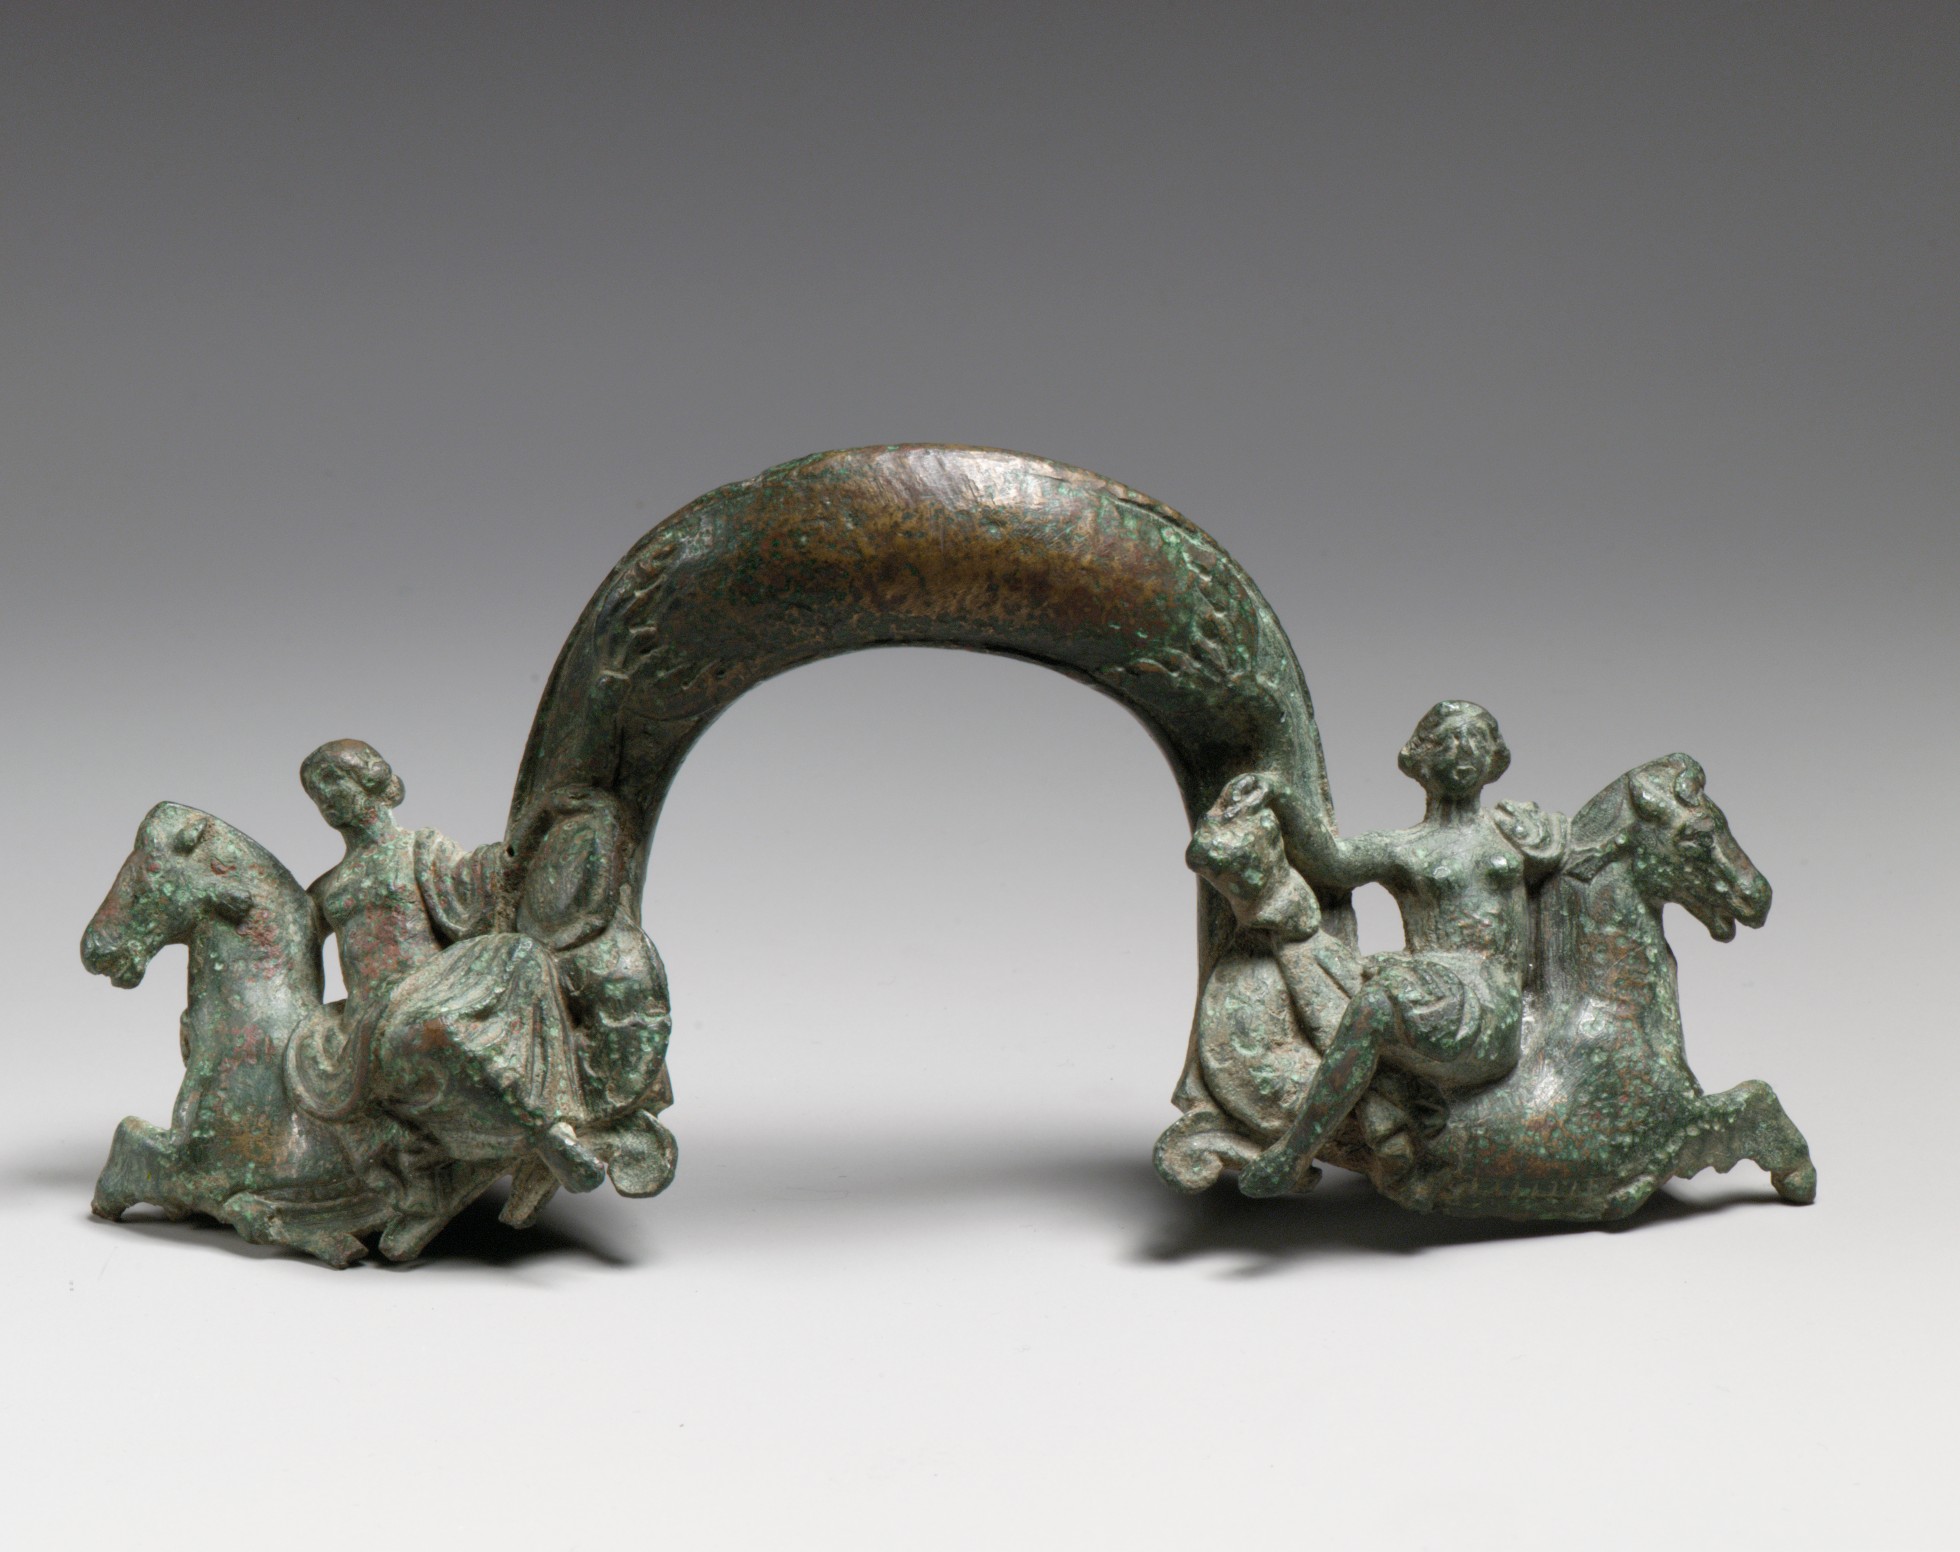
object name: handle of a bowl or footbath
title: Bronze handle of a shallow basin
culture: greek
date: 400-301 BCE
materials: bronze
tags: women,horses